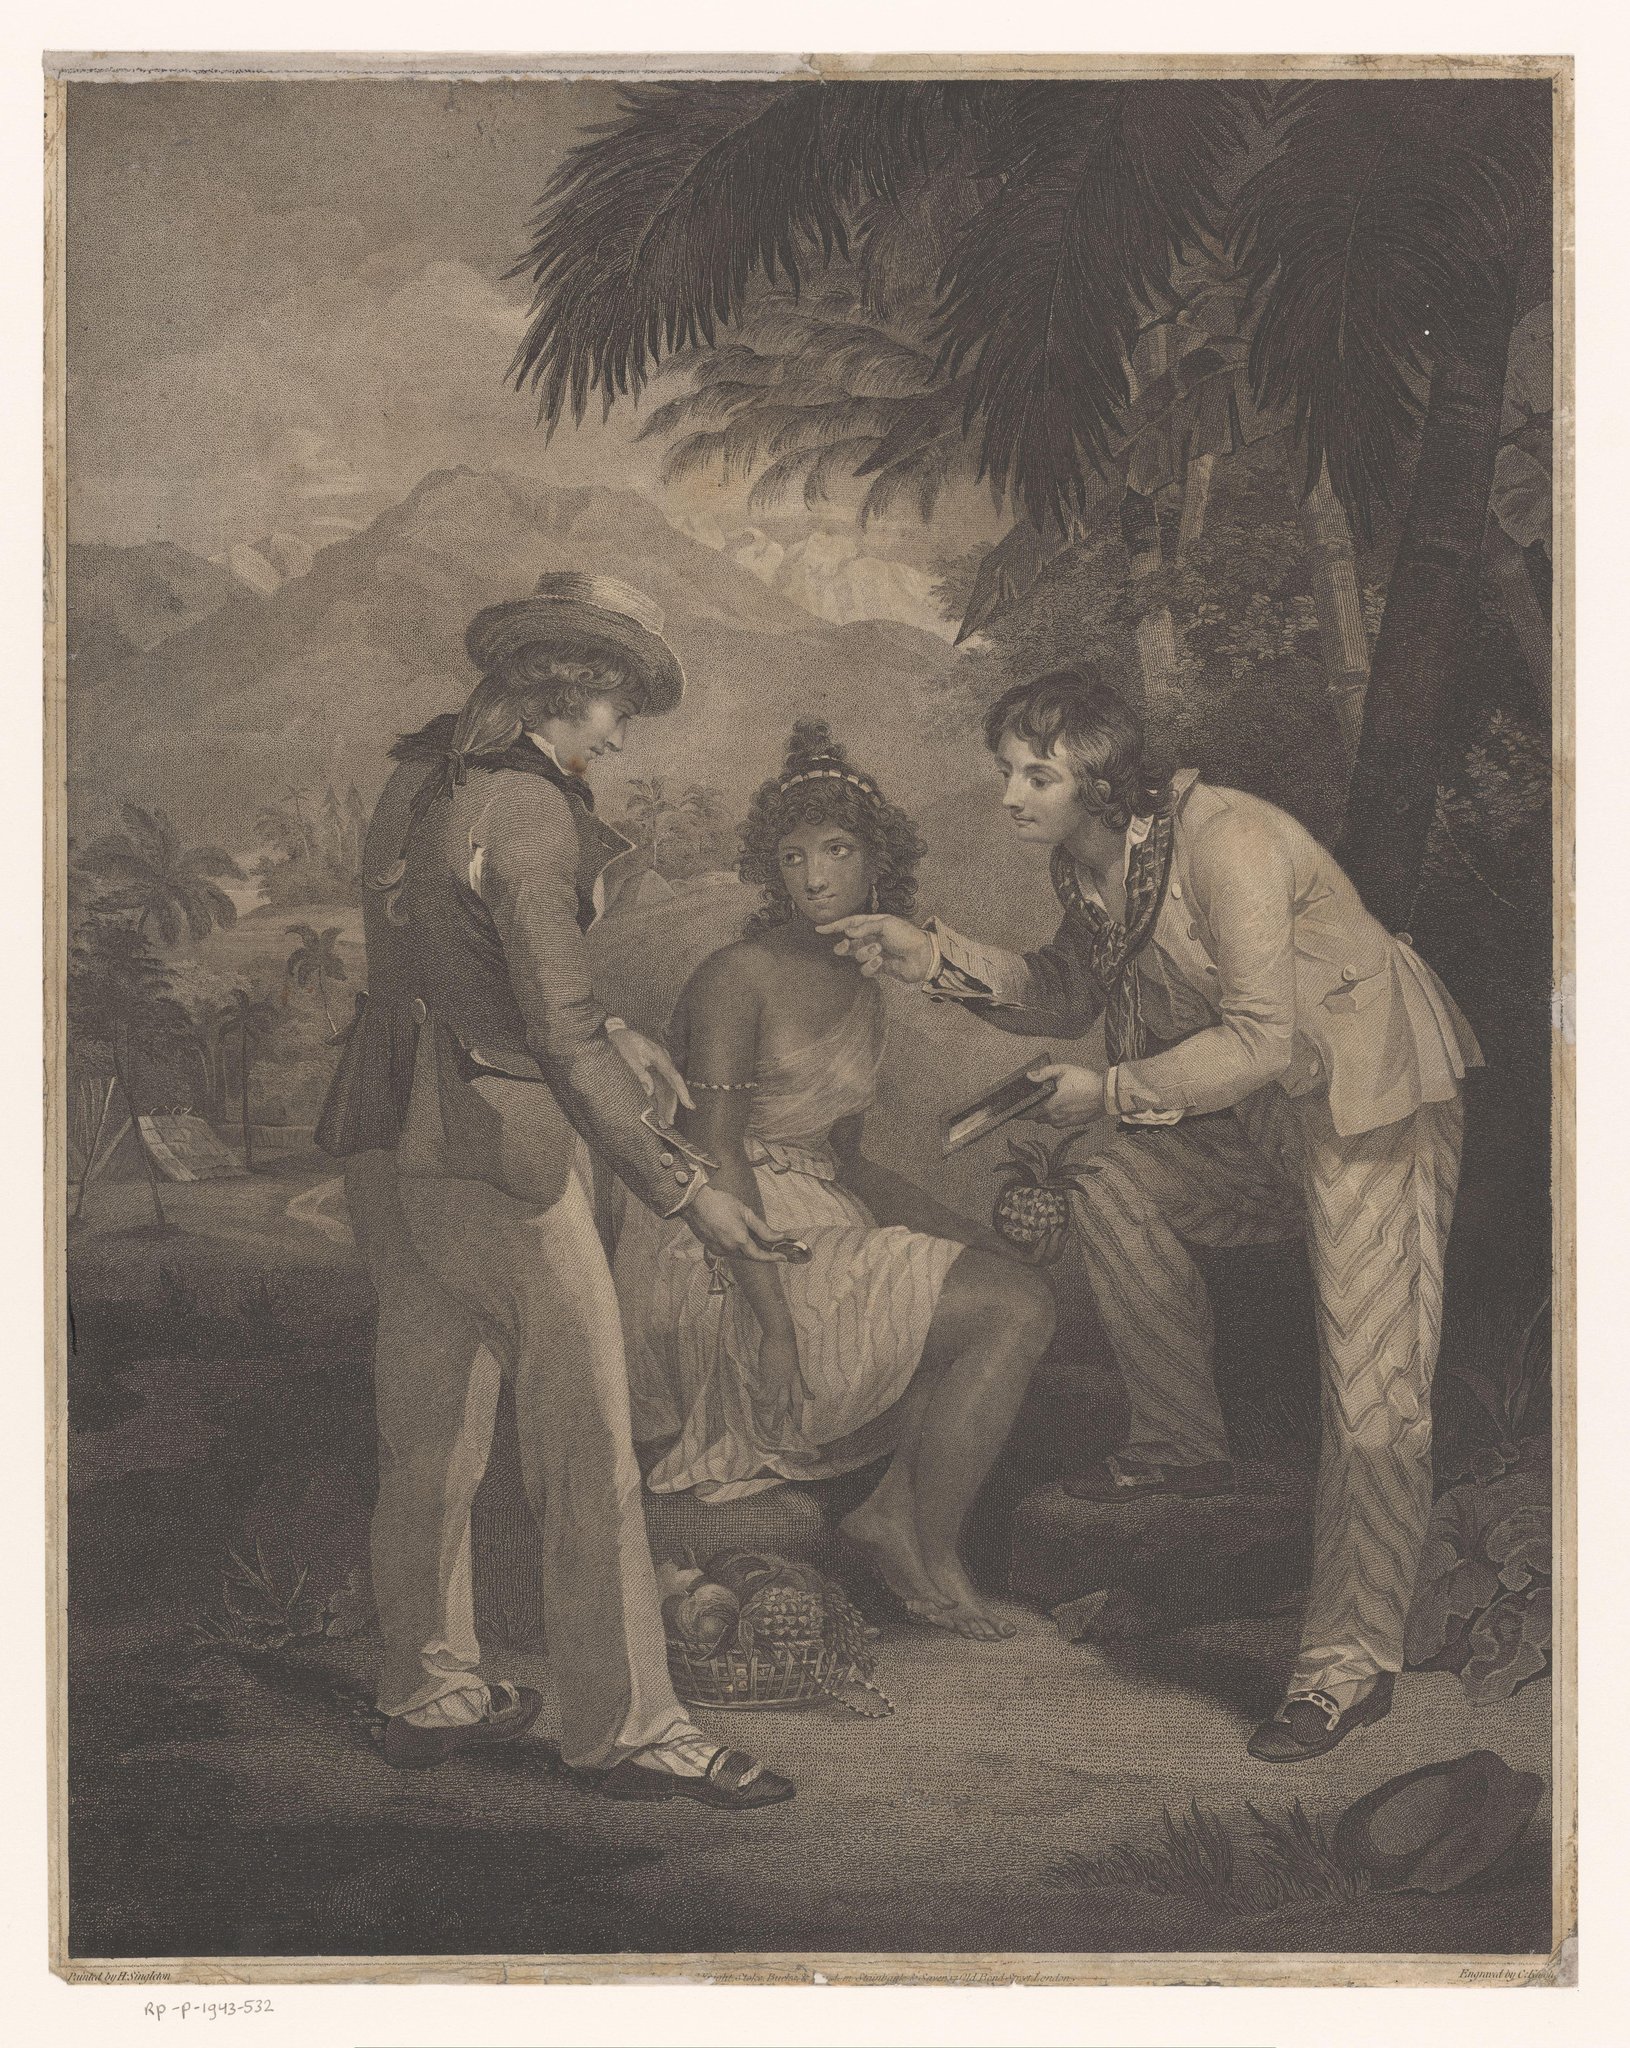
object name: print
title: Twee Britse matrozen bieden een horloge en spiegel voor het fruit van een Indiase vrouw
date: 1794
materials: paper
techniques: etching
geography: london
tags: bargaining, fruits: pineapple, landscapes in the non-temperate zone, exotic landscapes - kk - ideal landscapes, mirror, europeans: englishmen, sailor, watch, asiatic races and peoples: indians, mountains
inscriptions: collector's mark: Lugt 2228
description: De prent heeft als titel 'Scarcity in India' en vormt een paar met 'British Plenty'. De titel is hier afgesneden.